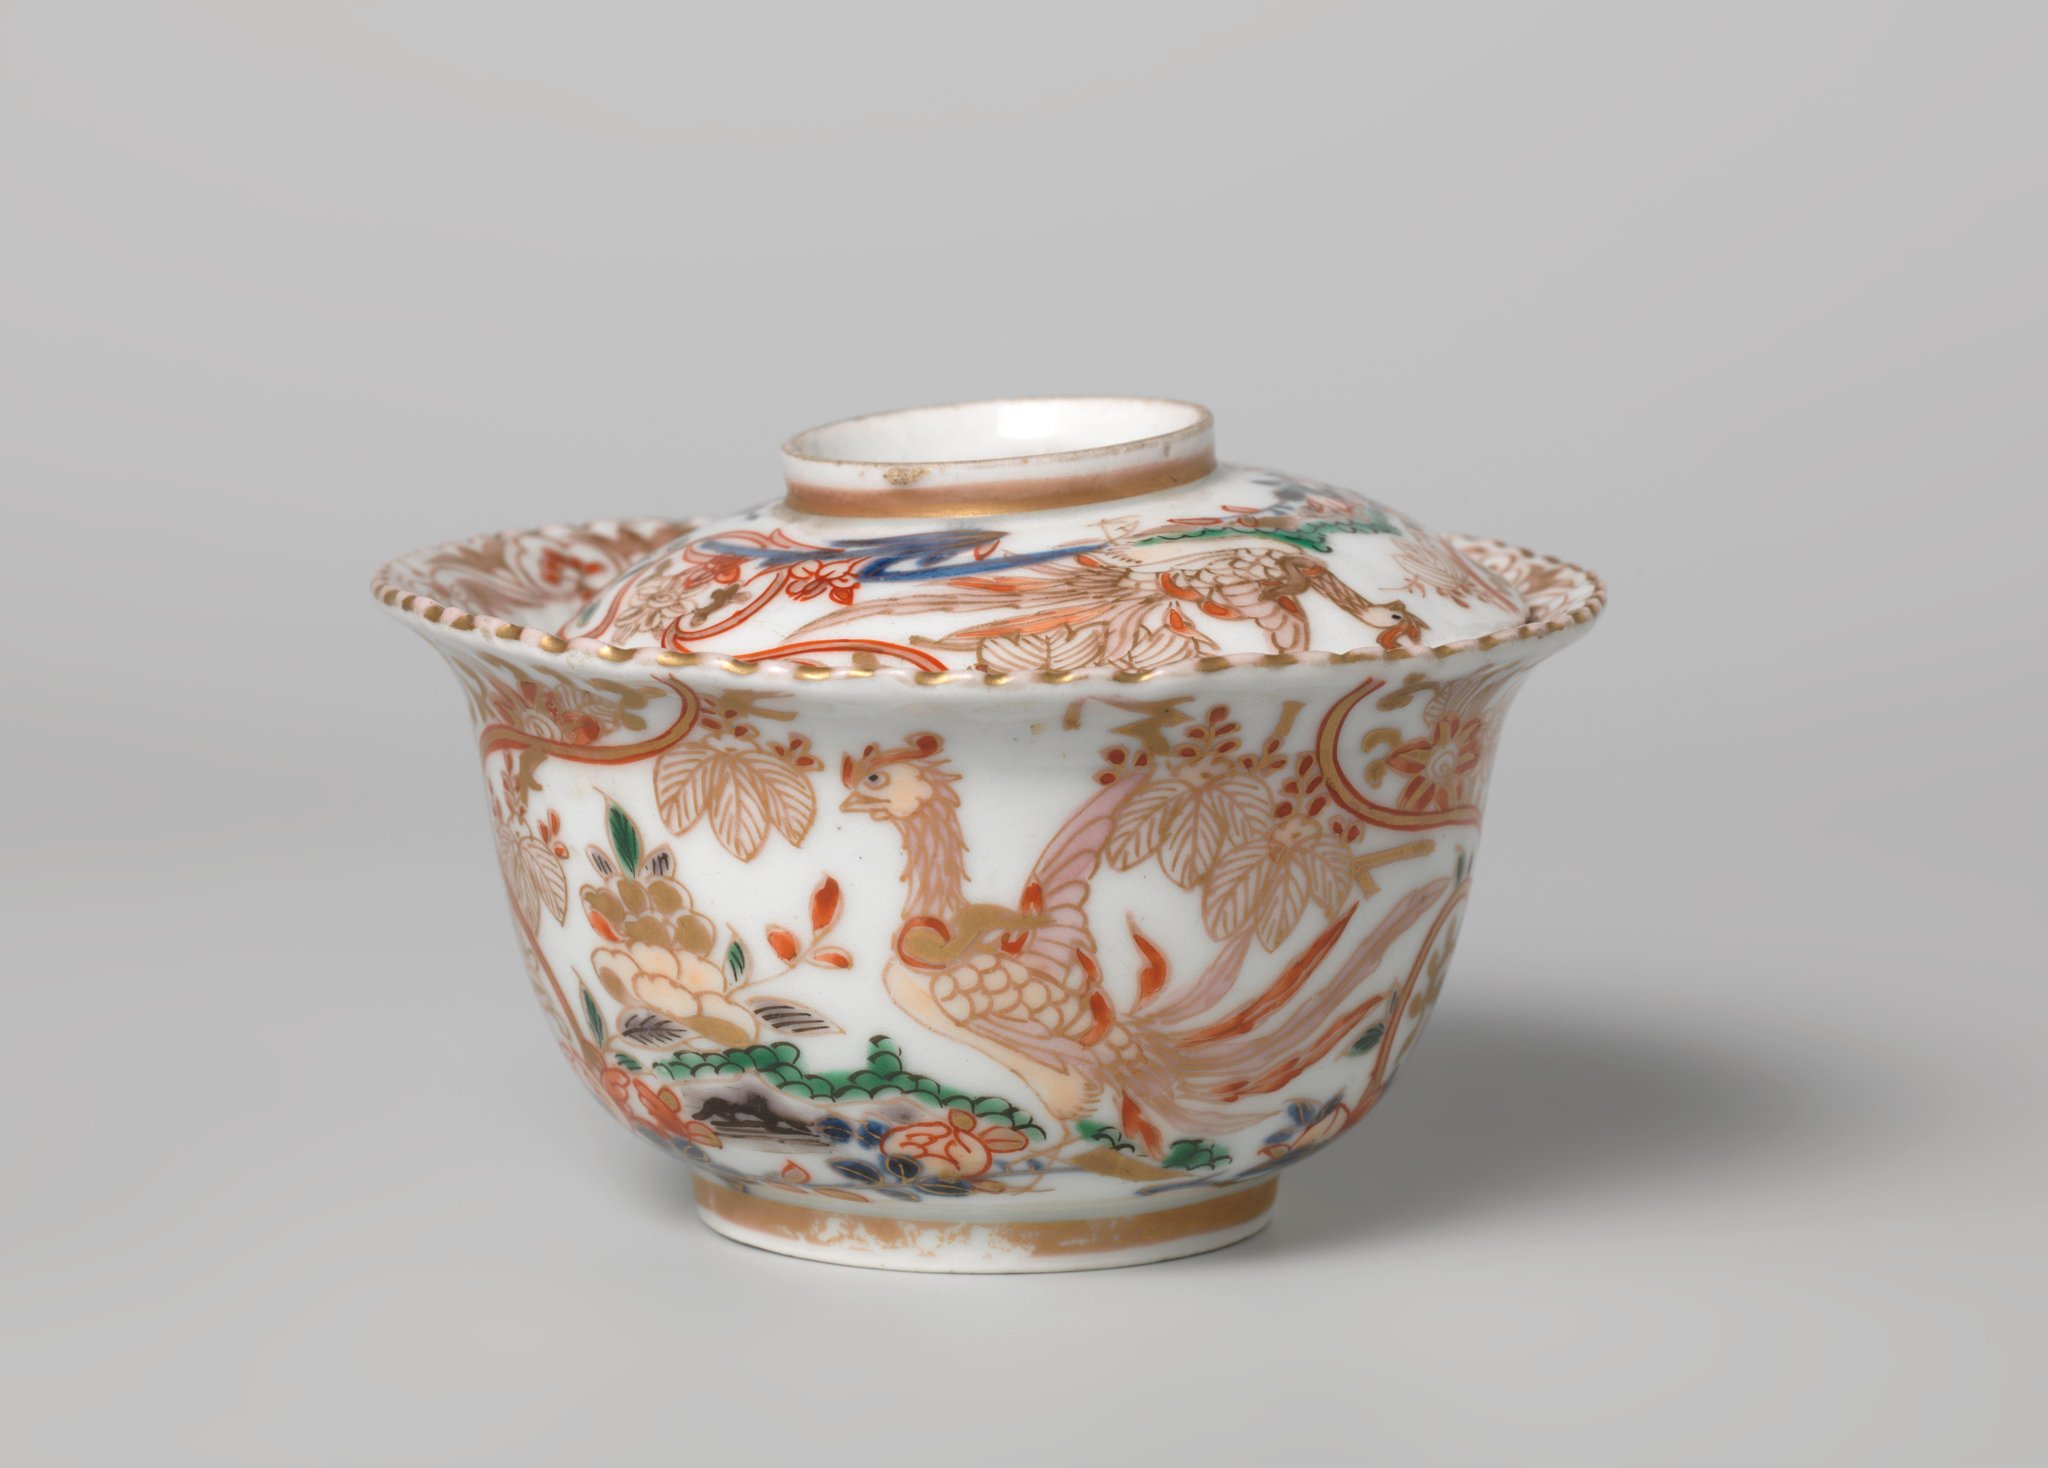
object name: covered bowl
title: Covered bowl with hoo-birds, flowering plants and floral scrolls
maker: Anonymous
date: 1700-1724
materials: cobalt, glaze, gold, paint, porcelain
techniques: firing, gilding, turning, vitrification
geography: japan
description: Kom en deksel, imari, met goud , hek met vegetatie, wand gelobdmet een feng huang tussen bloemen en ranke.